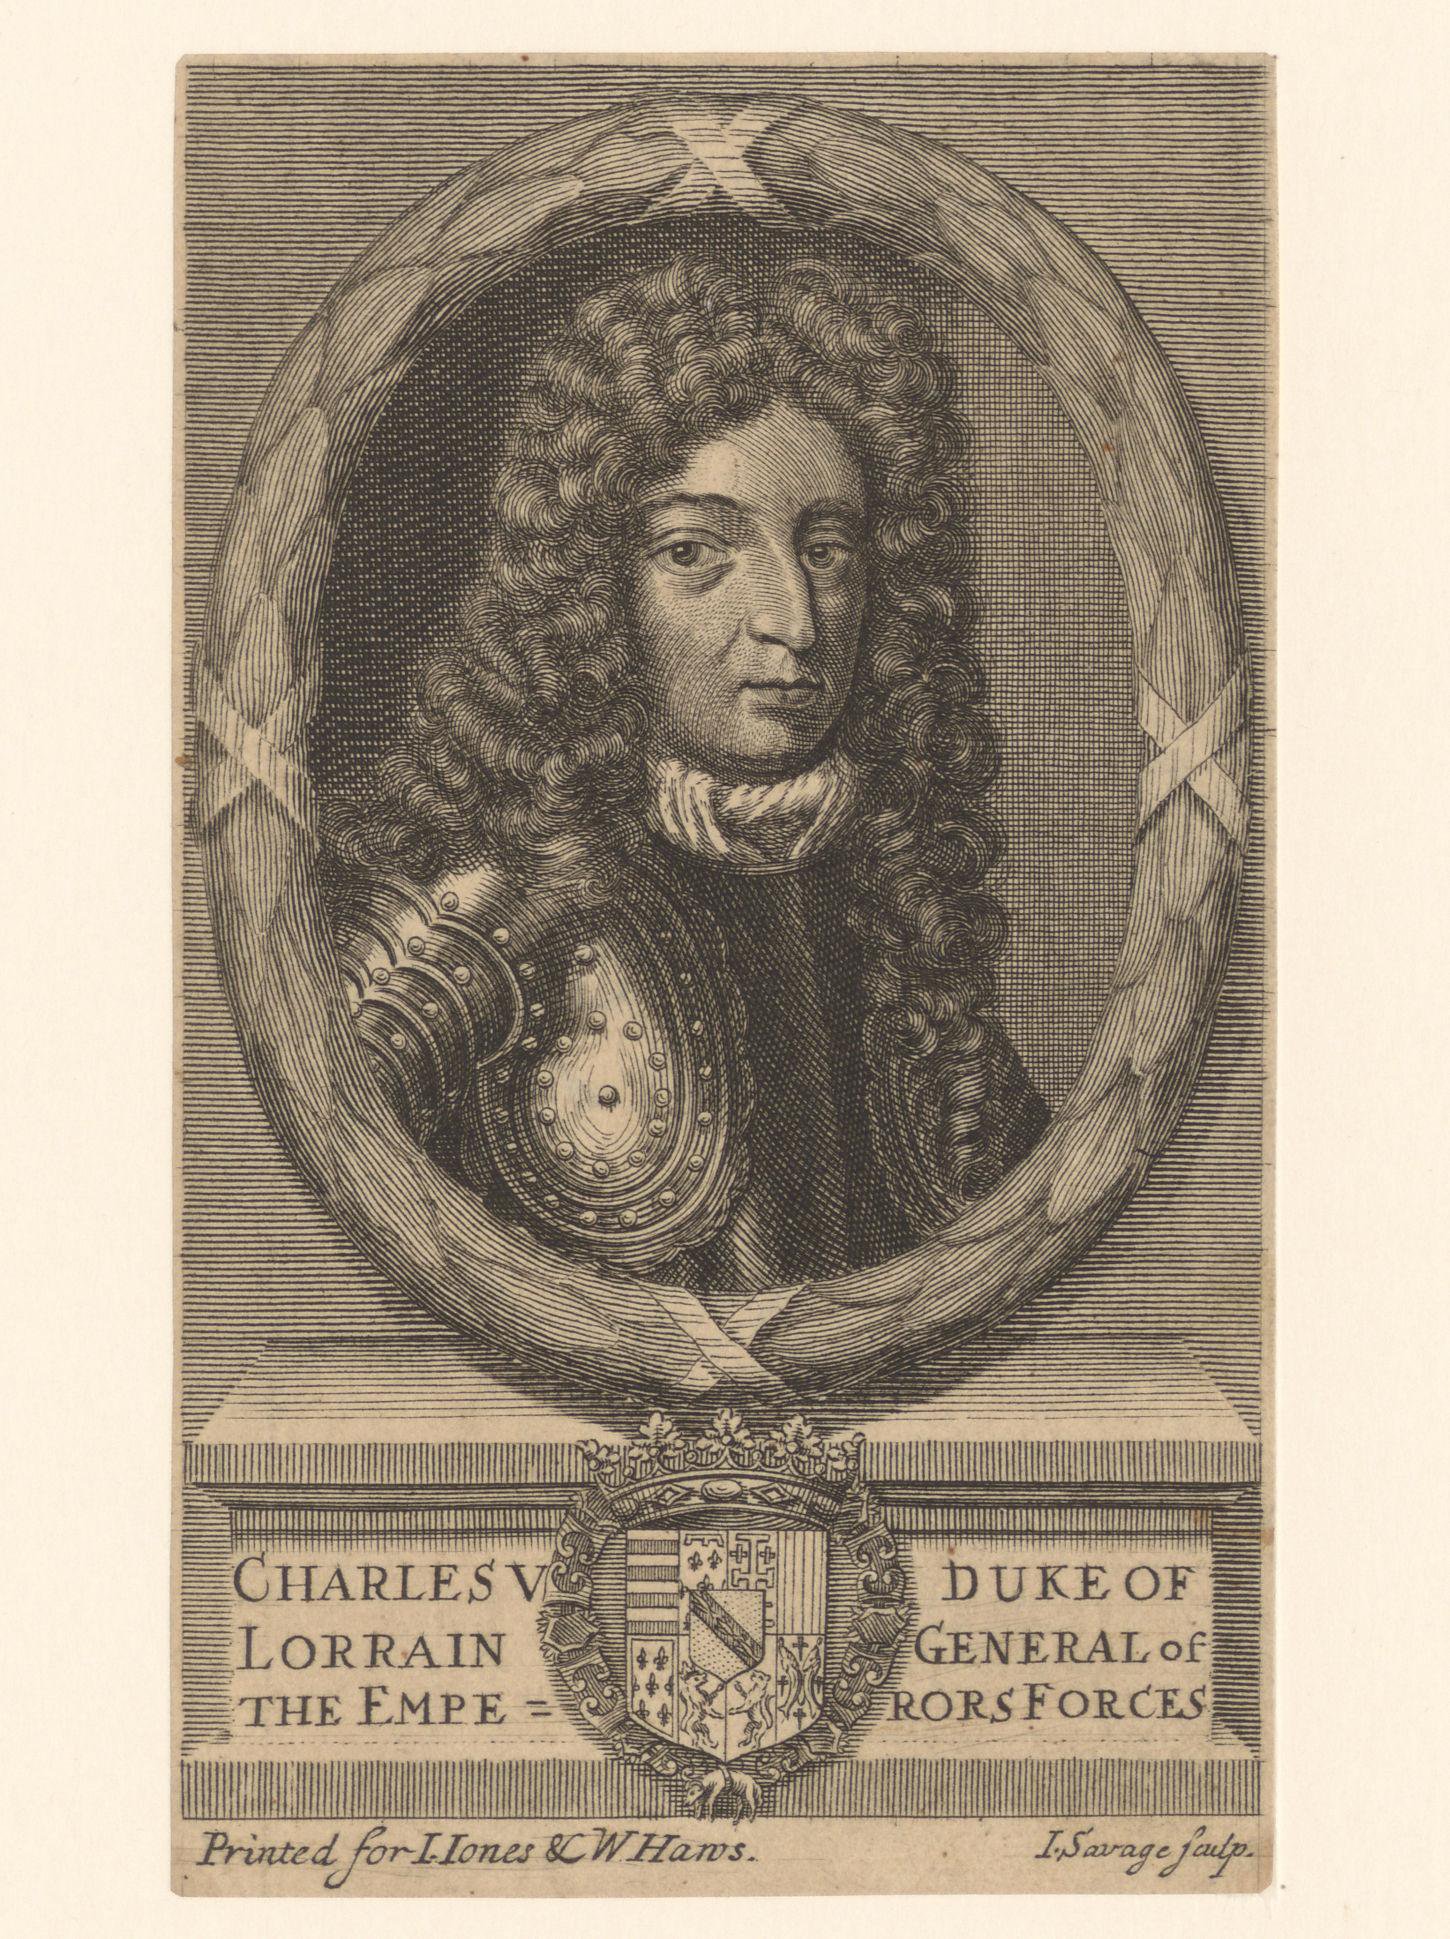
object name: print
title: Portret van Karel V van Lotharingen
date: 1777-1797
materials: paper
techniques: engraving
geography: london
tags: vienna, historical persons, politician, e.g. party leader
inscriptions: collector's mark: Lugt 2228